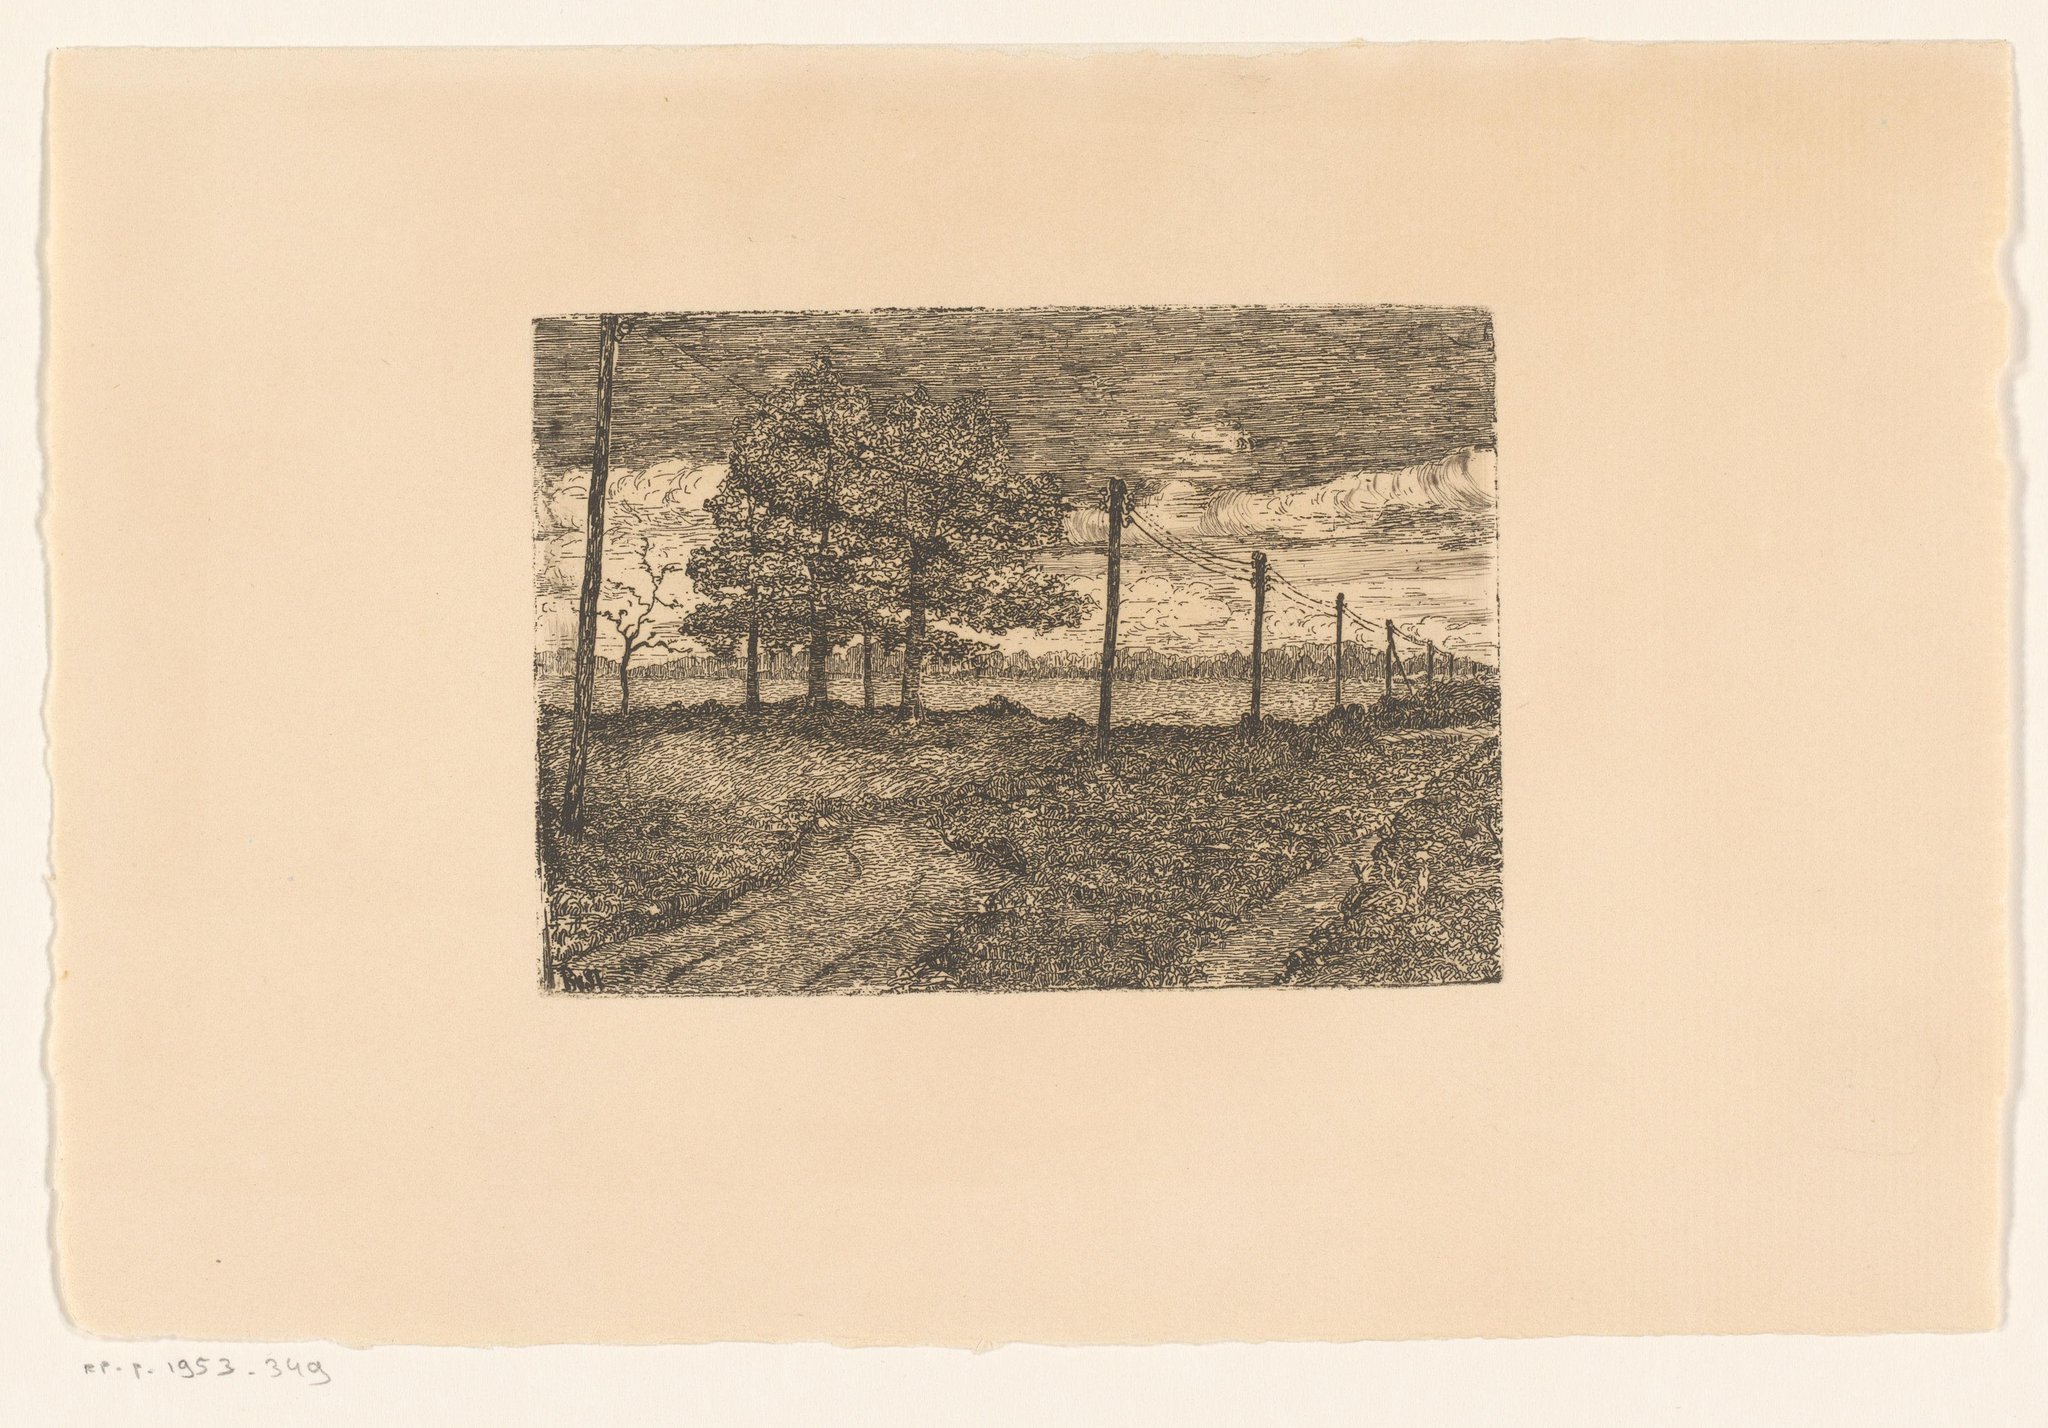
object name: print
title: Landweg met telegraafpalen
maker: theodora jacoba van bosse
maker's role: print maker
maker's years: 1874-1953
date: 1899-1953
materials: paper, ink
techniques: etching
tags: landscapes, telegraph pole, telephone pole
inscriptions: monogram: ‘[?]’, collector's mark: Lugt 2228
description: Vlak landschap met diagonaal een rij telegraafpalen, links daarvan een boomgroep.